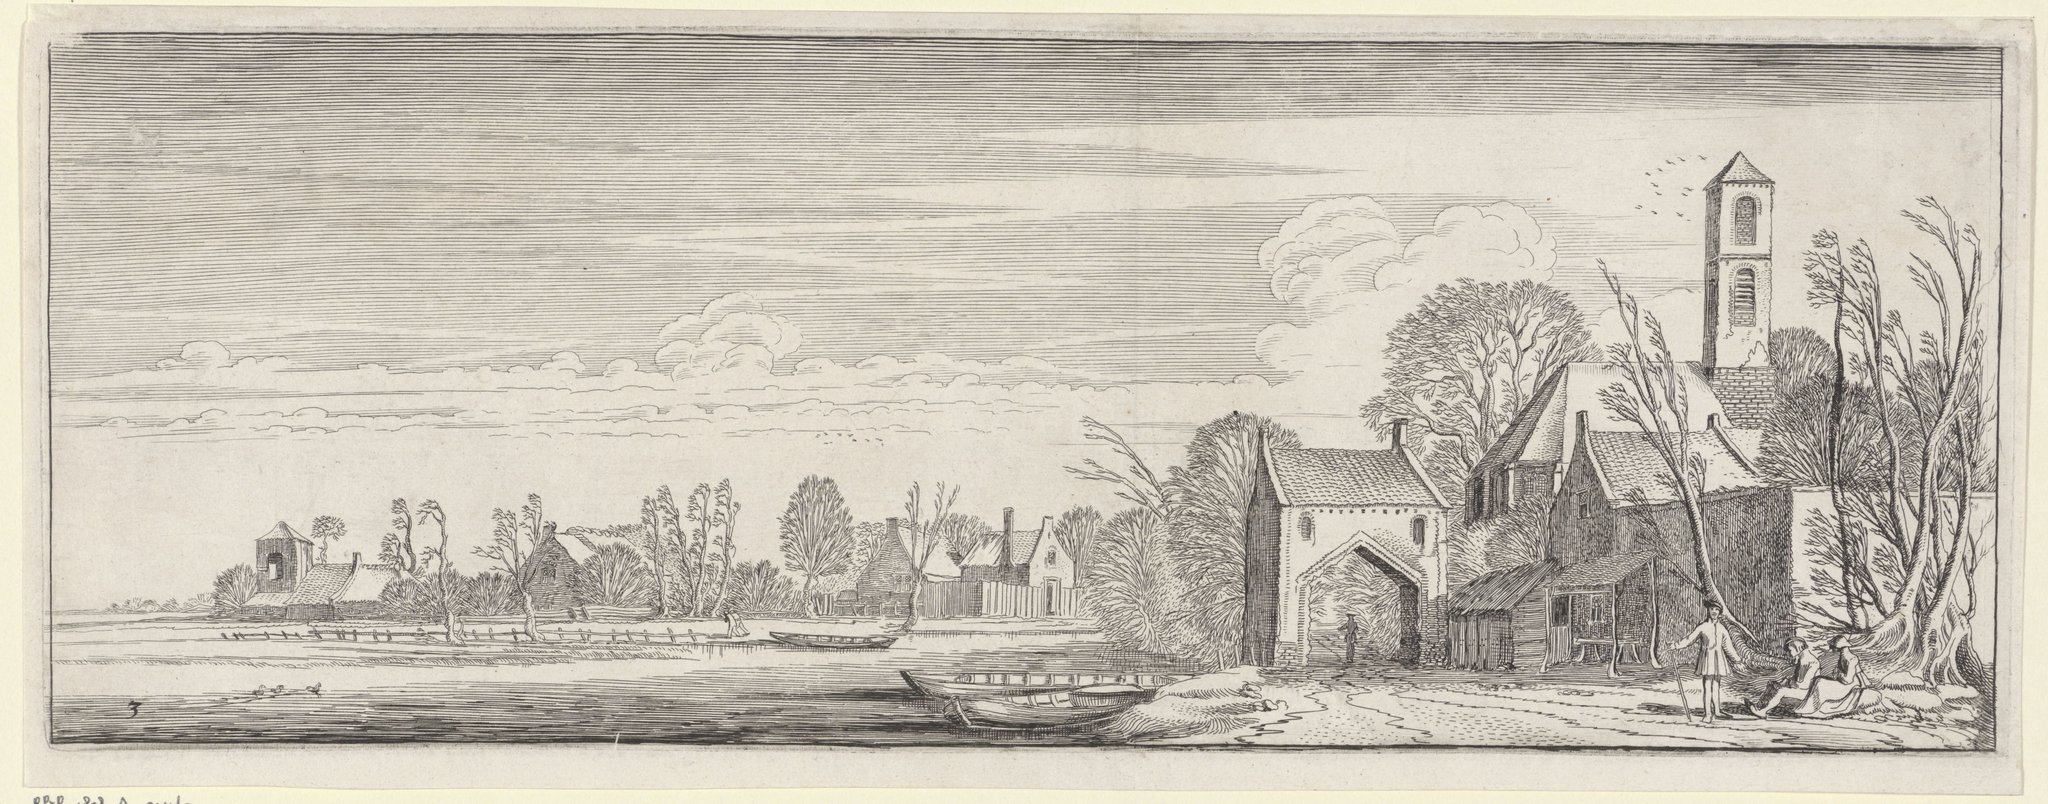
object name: print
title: Landschappen van oblong formaat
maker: jan van de velde (ii)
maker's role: draughtsman, painter, print maker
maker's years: 1593-1641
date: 1603-1641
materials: paper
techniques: etching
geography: northern netherlands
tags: prospect of village, silhouette of village, lake, village-gate, parts of church exterior and annexes: tower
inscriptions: collector's mark: Lugt 964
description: Figuren op een pad bij een poort naar en dorp aan een meer. Links aangemeerde sloepen. Prent uit een serie van acht.